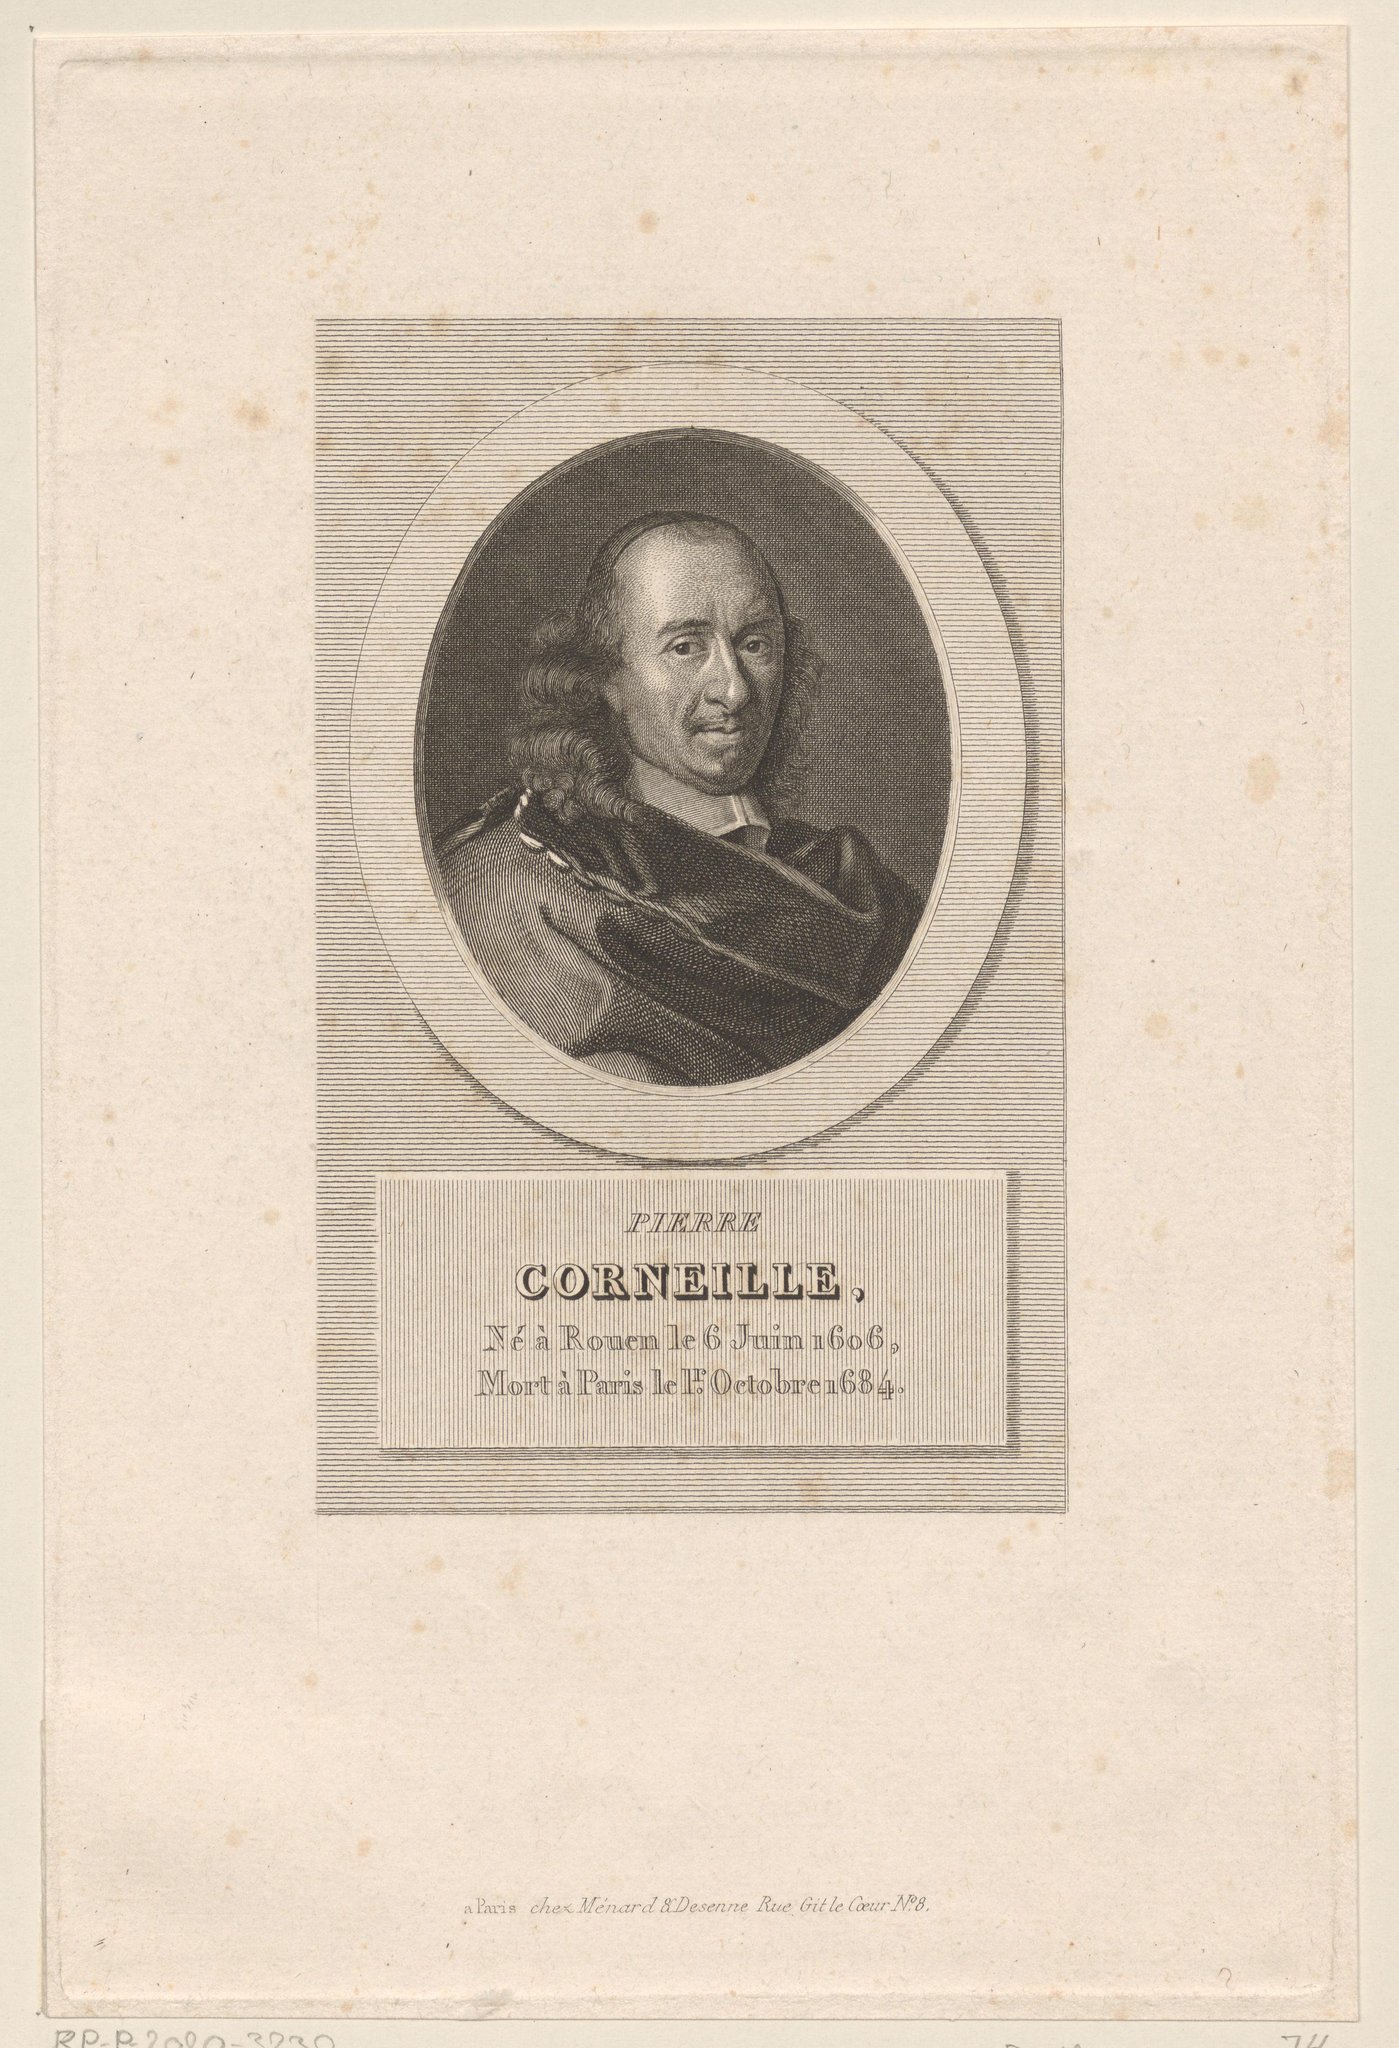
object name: print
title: Portret van Pierre Corneille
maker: Anonymous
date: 1816-1831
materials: paper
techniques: engraving, etching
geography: paris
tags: pierre corneille, historical persons